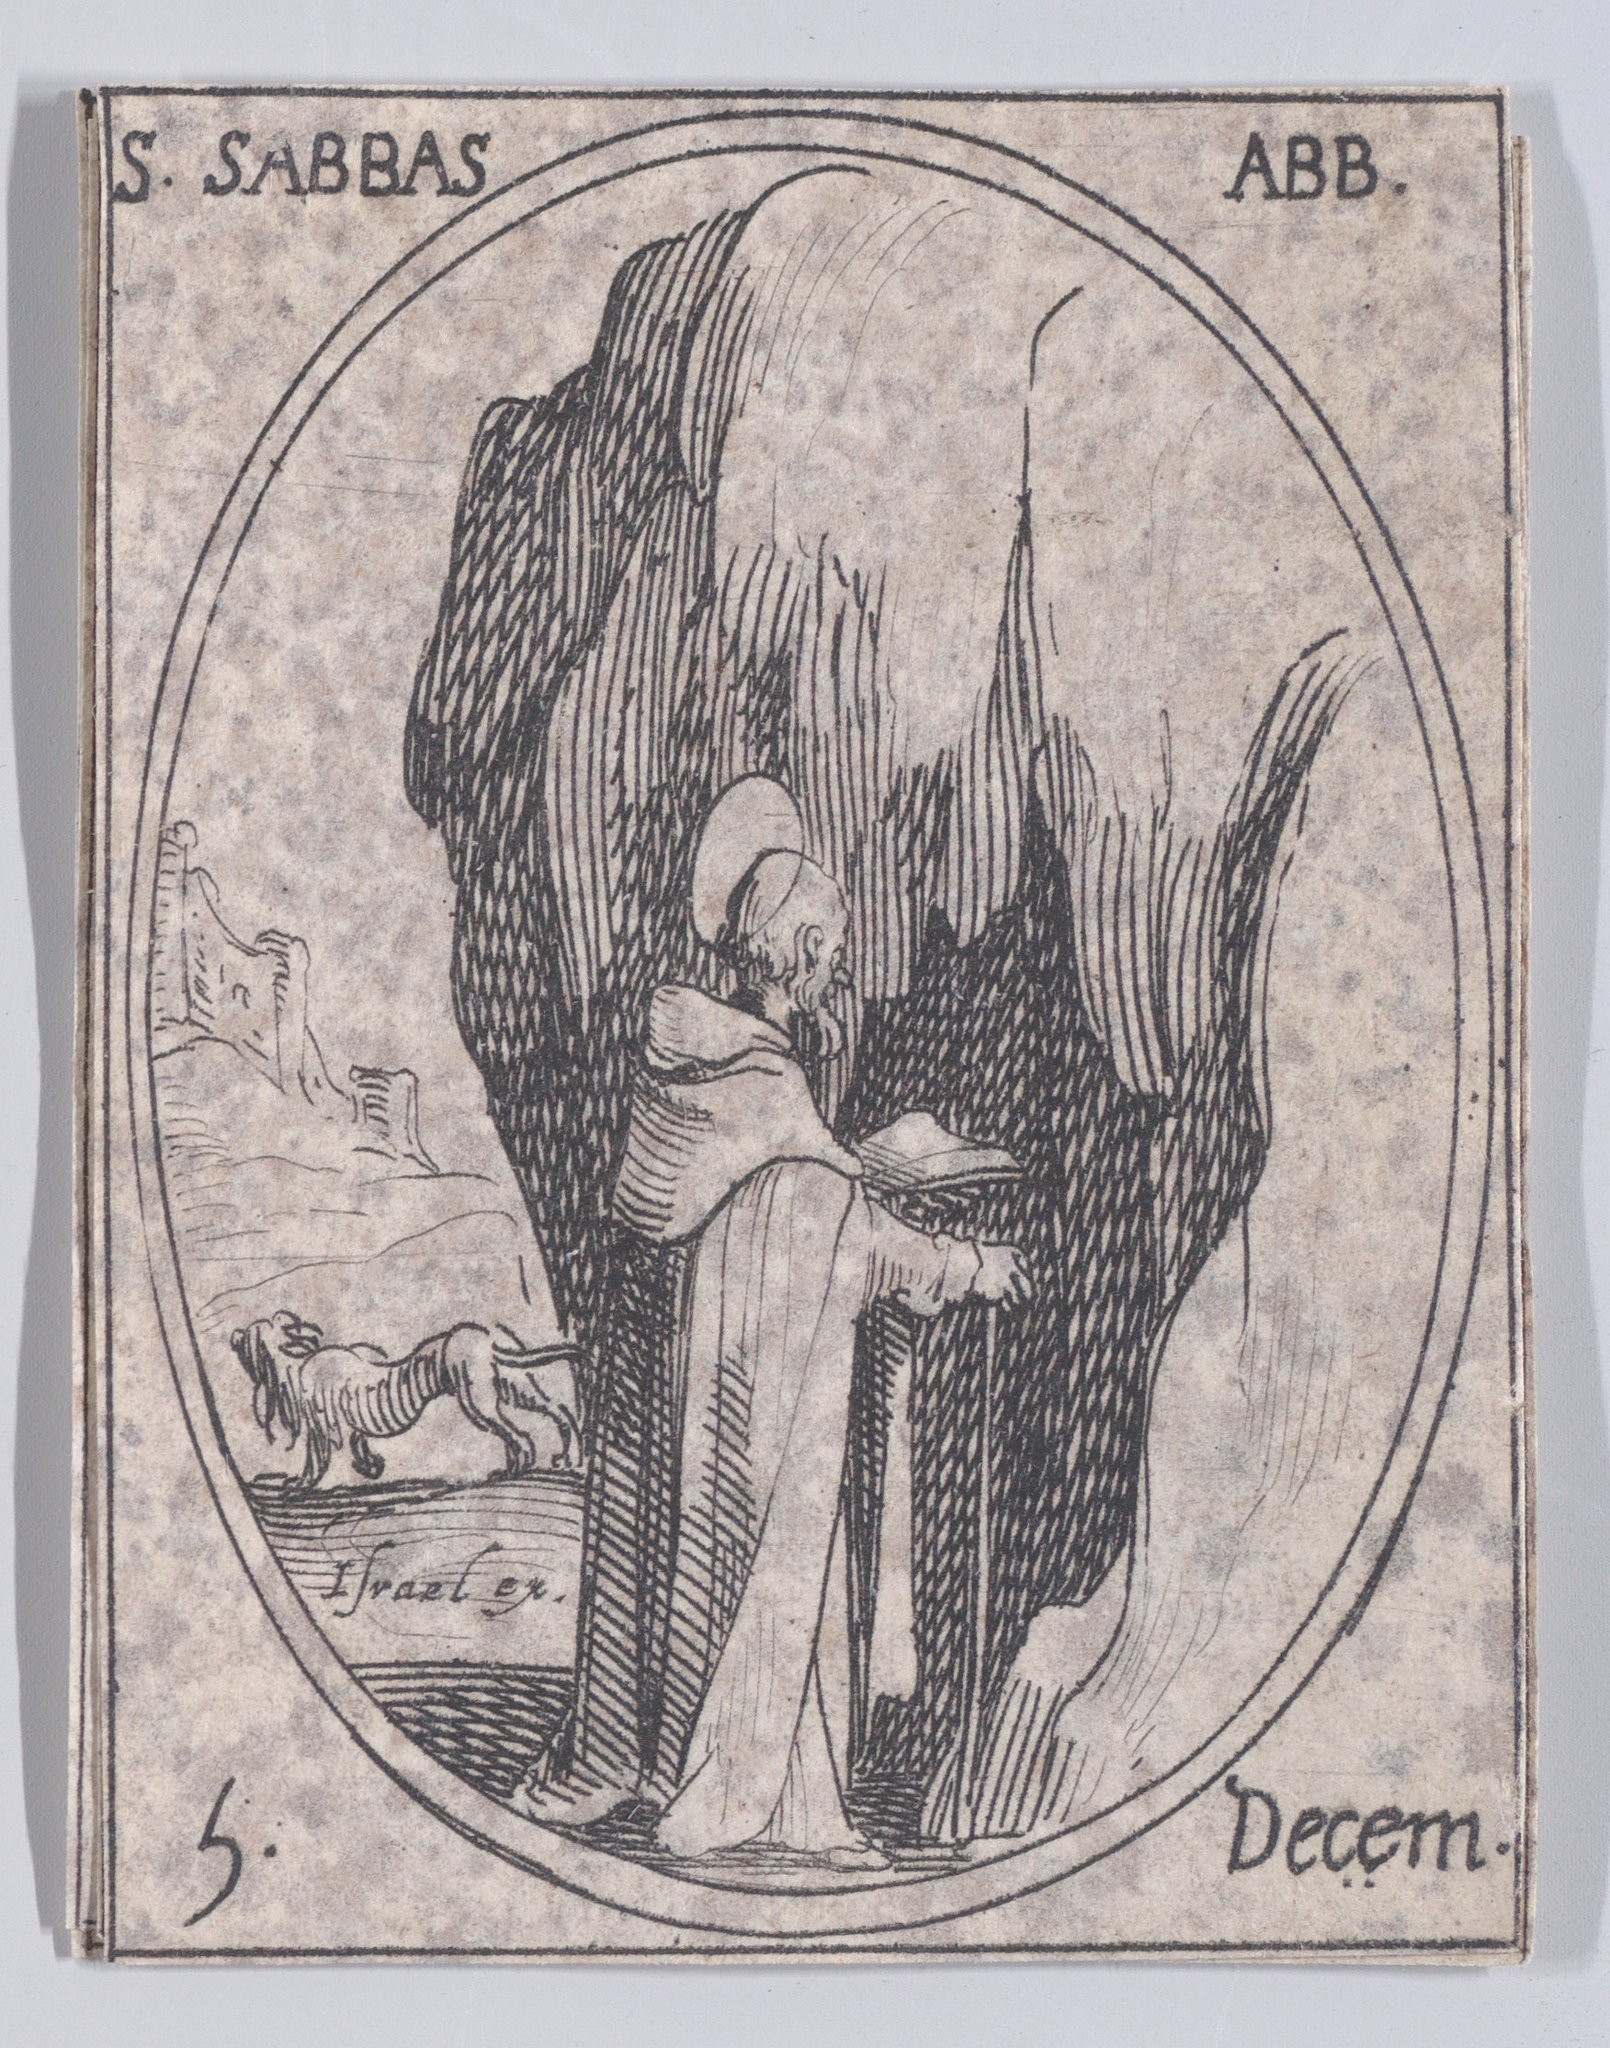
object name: print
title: S. Sabas, abbe (St. Sabas, Abbot), December 5th, from "Les Images De Tous Les Saincts et Saintes de L'Année" (Images of All of the Saints and Religious Events of the Year)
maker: jacques callot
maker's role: artist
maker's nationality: french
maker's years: 1592-1635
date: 1636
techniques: etching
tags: men,saints